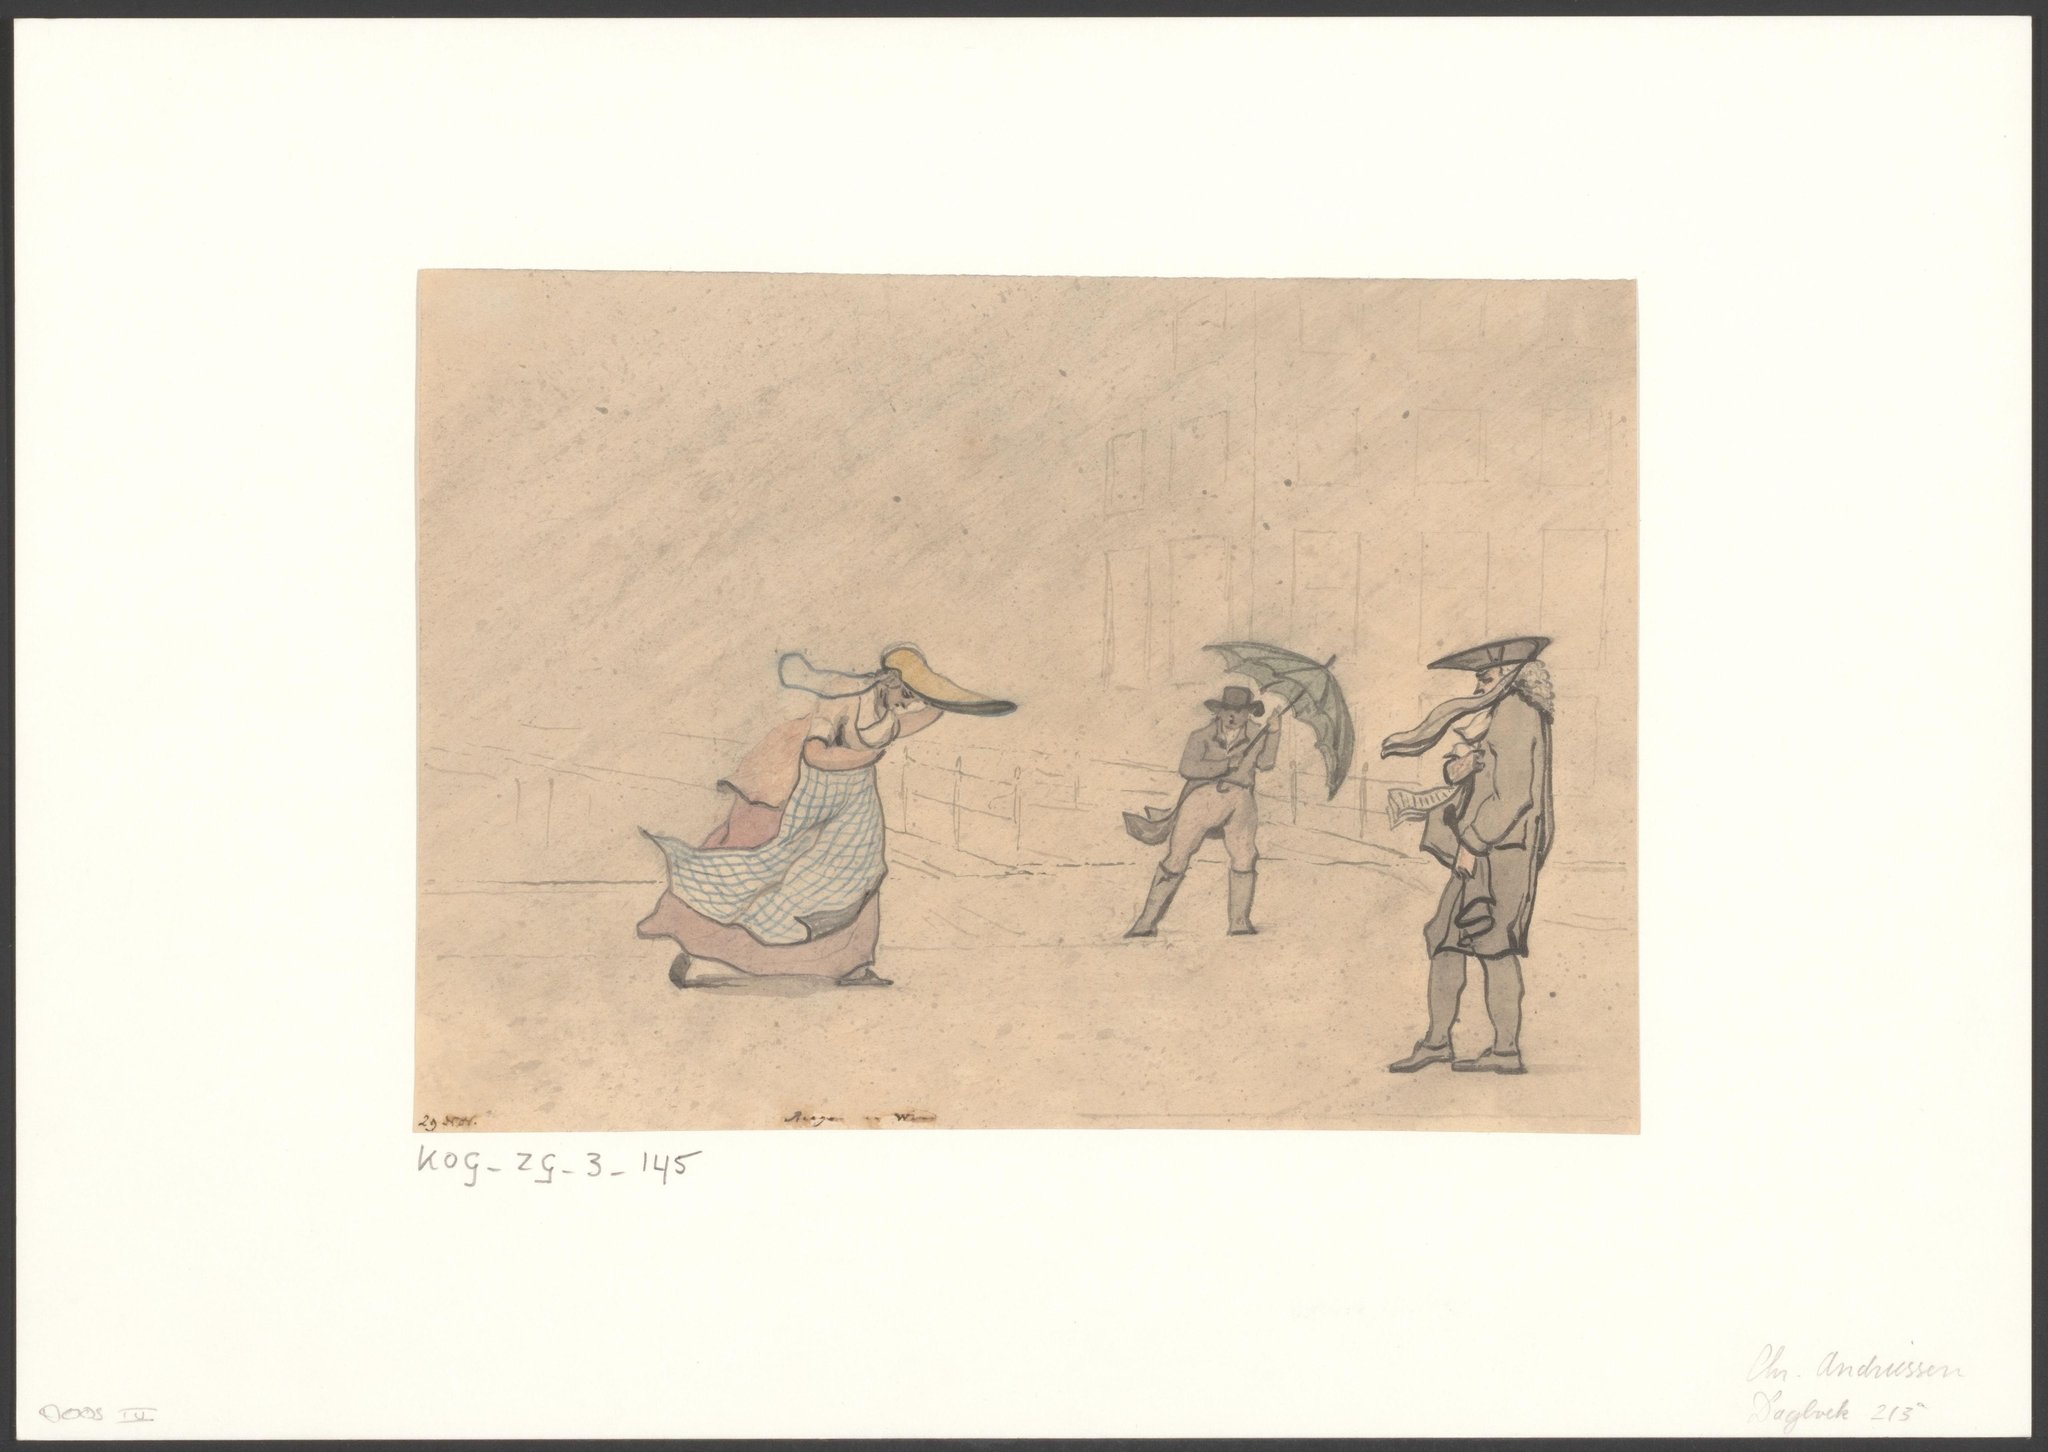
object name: drawing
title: Dienstmeid met een zeer lange luifelhoed, een aanspreker en Christiaan Andriessen trotseren wind en regen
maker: christiaan andriessen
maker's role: draughtsman, print maker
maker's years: 1775-1846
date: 1806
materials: ink, paper, pencil, watercolor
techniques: brush, pen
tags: amsterdam, print maker, draughtsman, christiaan andriessen, oral announcement (of death), undertaker's man, head-gear, storm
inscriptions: signature: ‘J Andriessen’, inscription: ‘22 julij Reegen en Wind’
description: Dagboekblad uit het getekende dagboek dat Christiaan Andriessen bijhield van 1805 tot en met 1808.